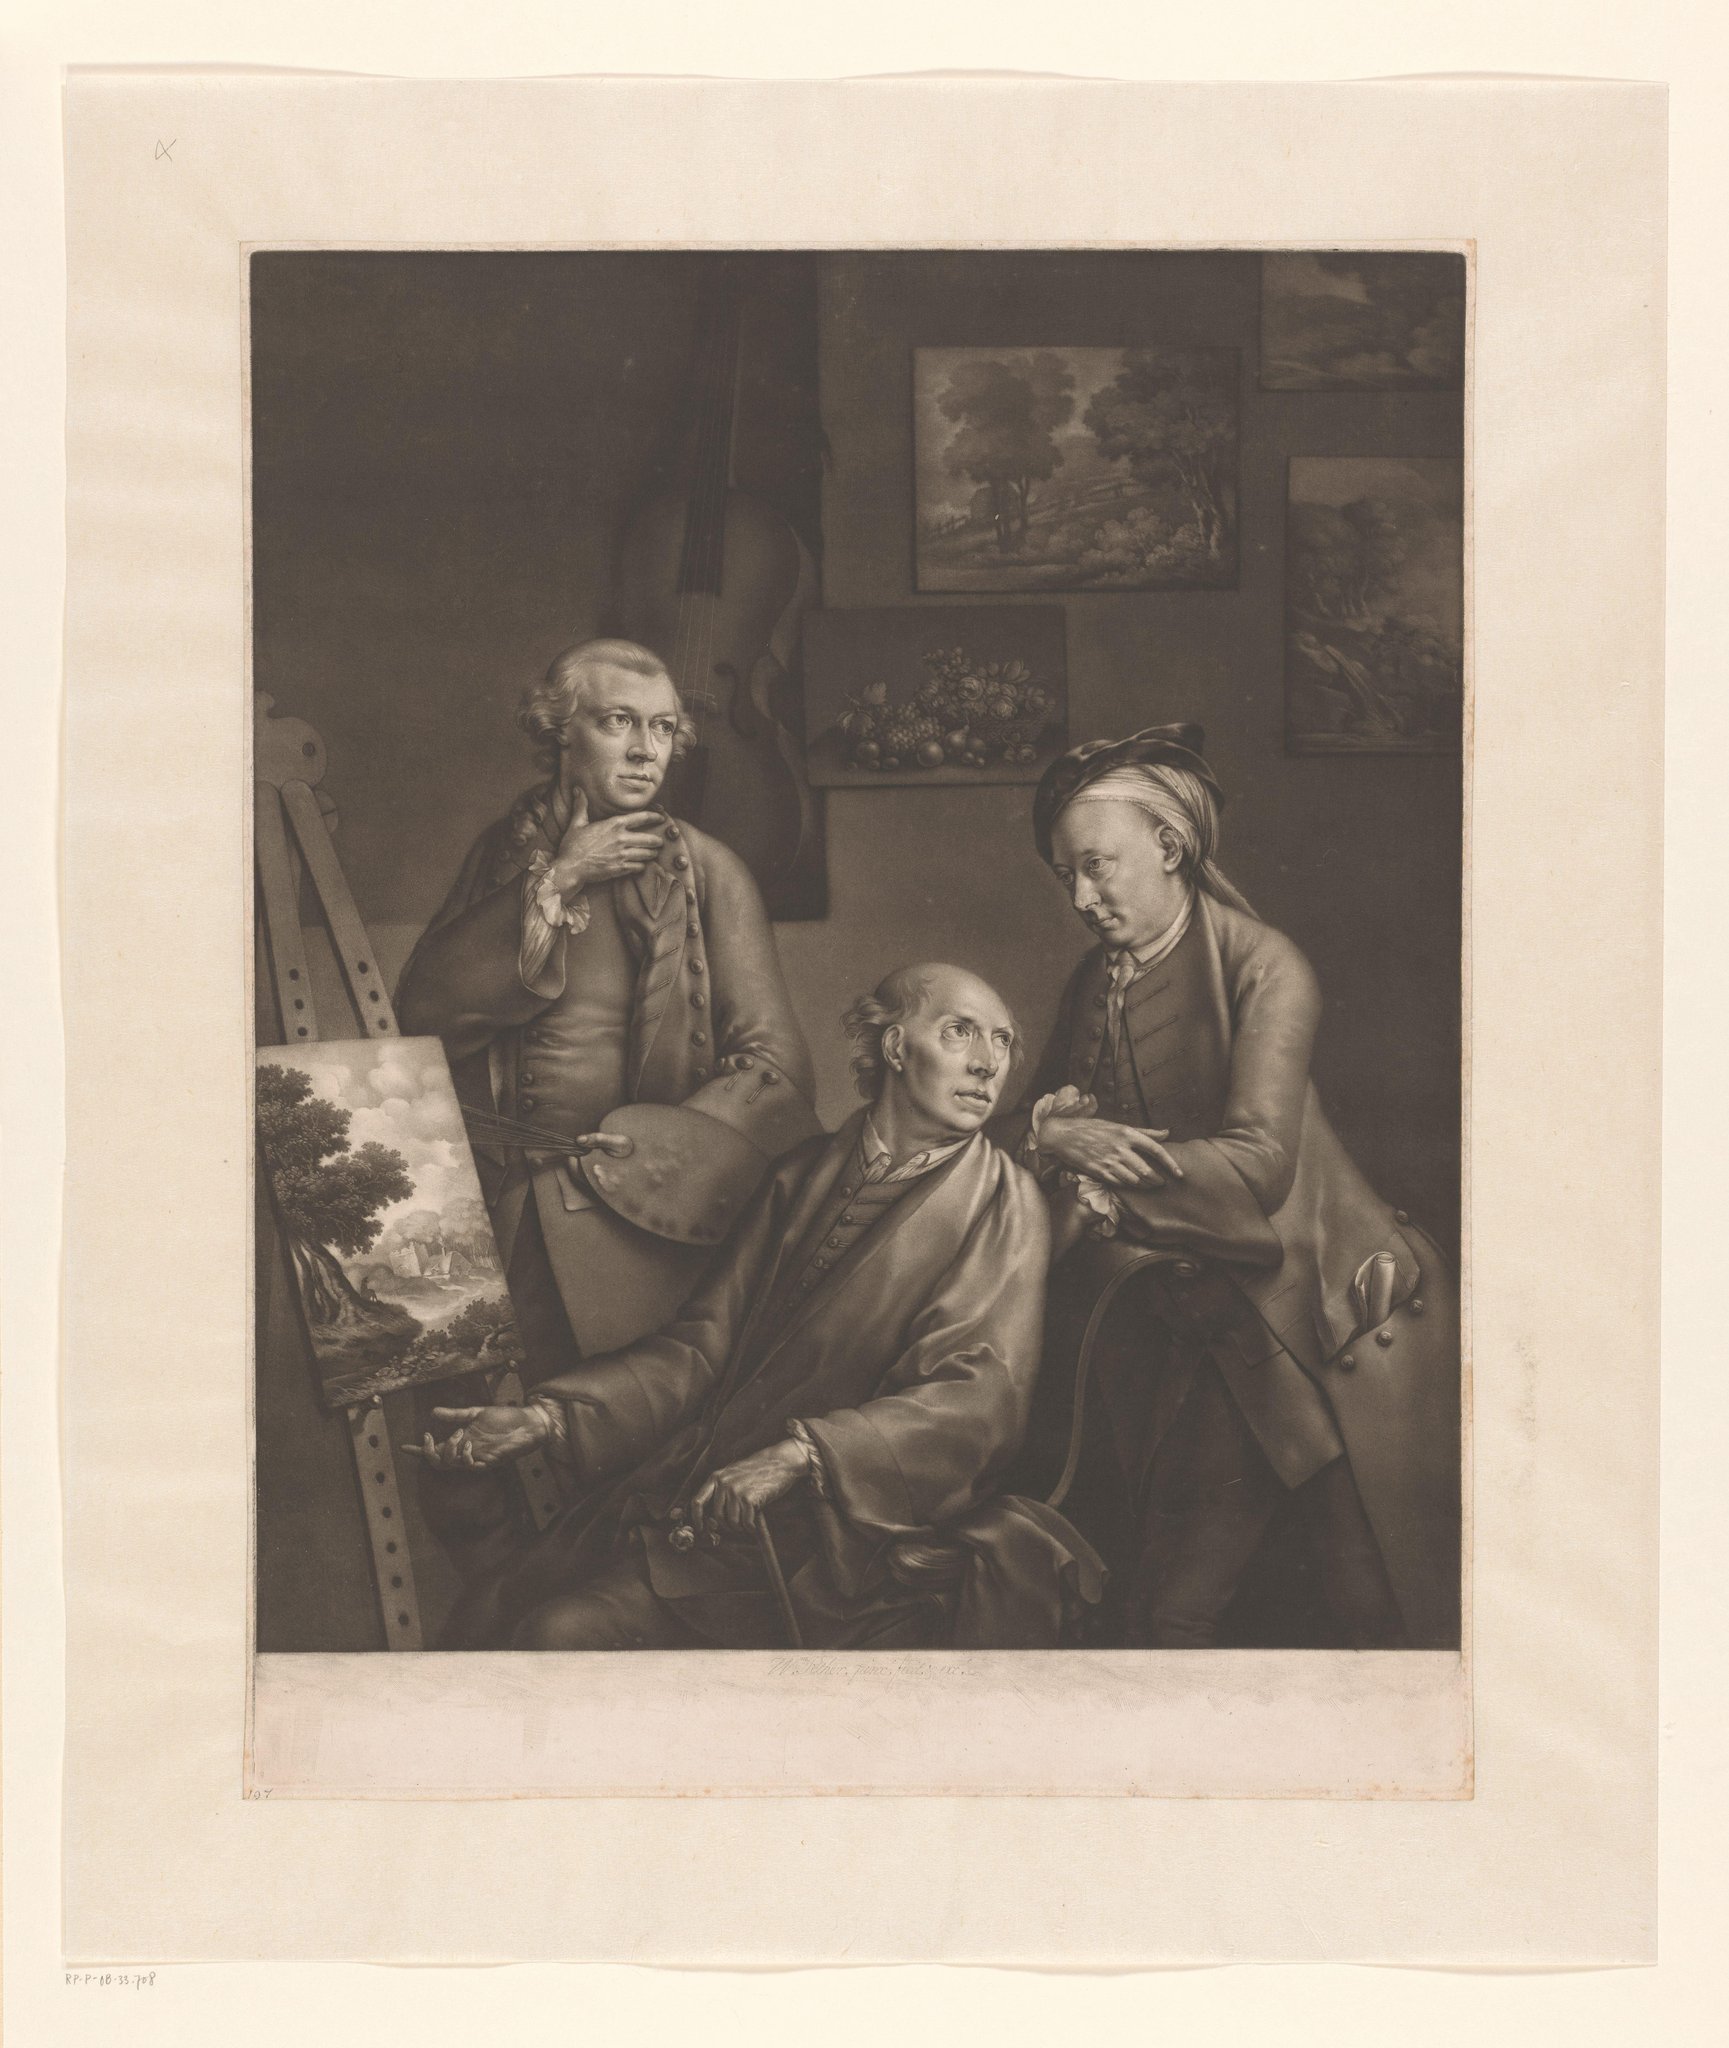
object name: print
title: Portret van William, John en George Smith of Chichester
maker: william pether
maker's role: print maker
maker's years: 1731-1795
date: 1741-1765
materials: paper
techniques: mezzotint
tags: print maker, william smith of chichester, publisher, george smith of chichester, john smith of chichester, historical persons, portrait, self-portrait of painter, brothers (second degree family relationships)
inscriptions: collector's mark: Lugt 240